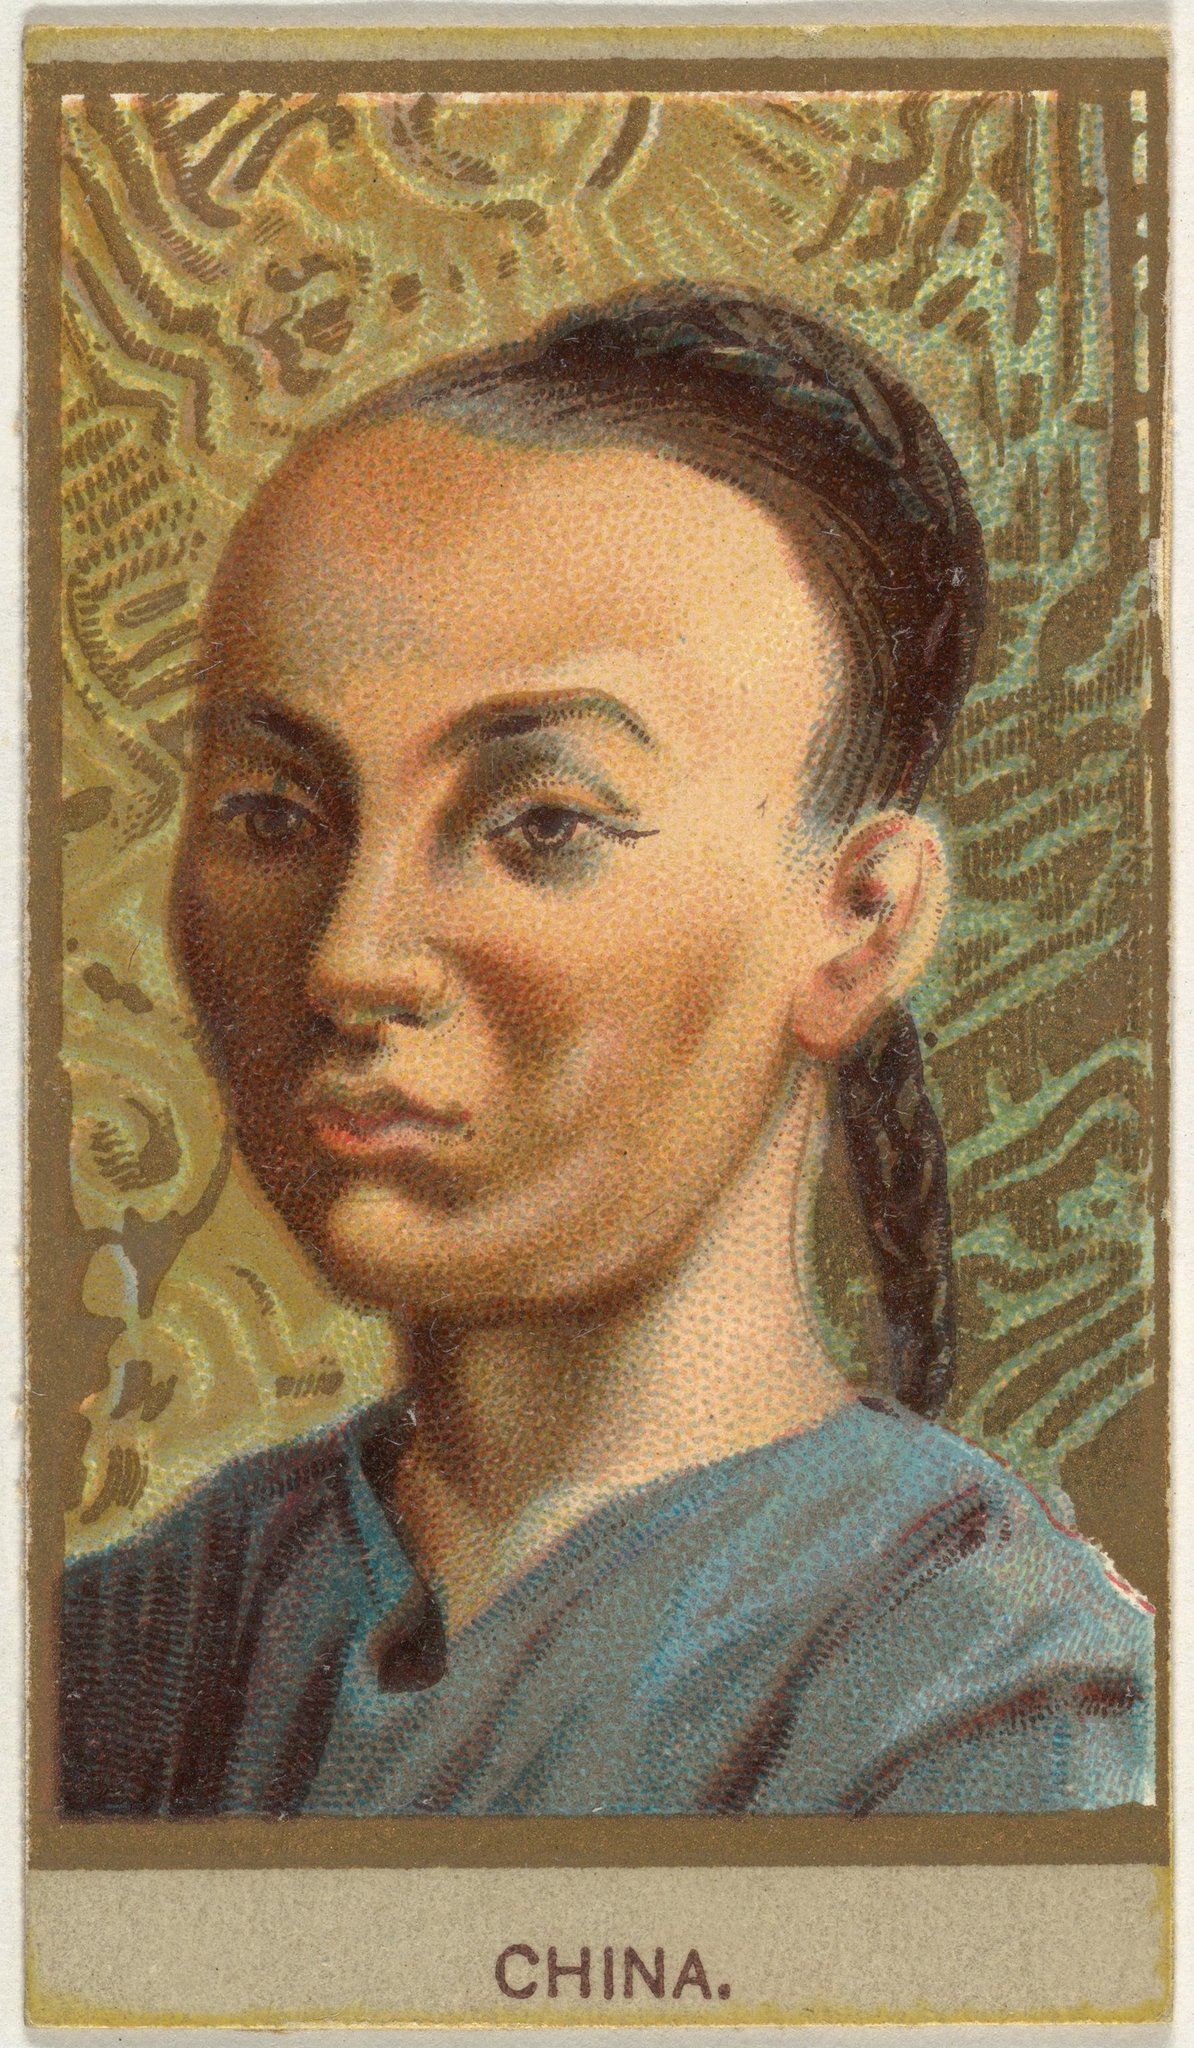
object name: print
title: China, from the Races of Mankind series (T181) issued by Abdul Cigarettes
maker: abdul cigarettes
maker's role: publisher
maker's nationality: american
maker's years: 1881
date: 1881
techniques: color lithograph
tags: women